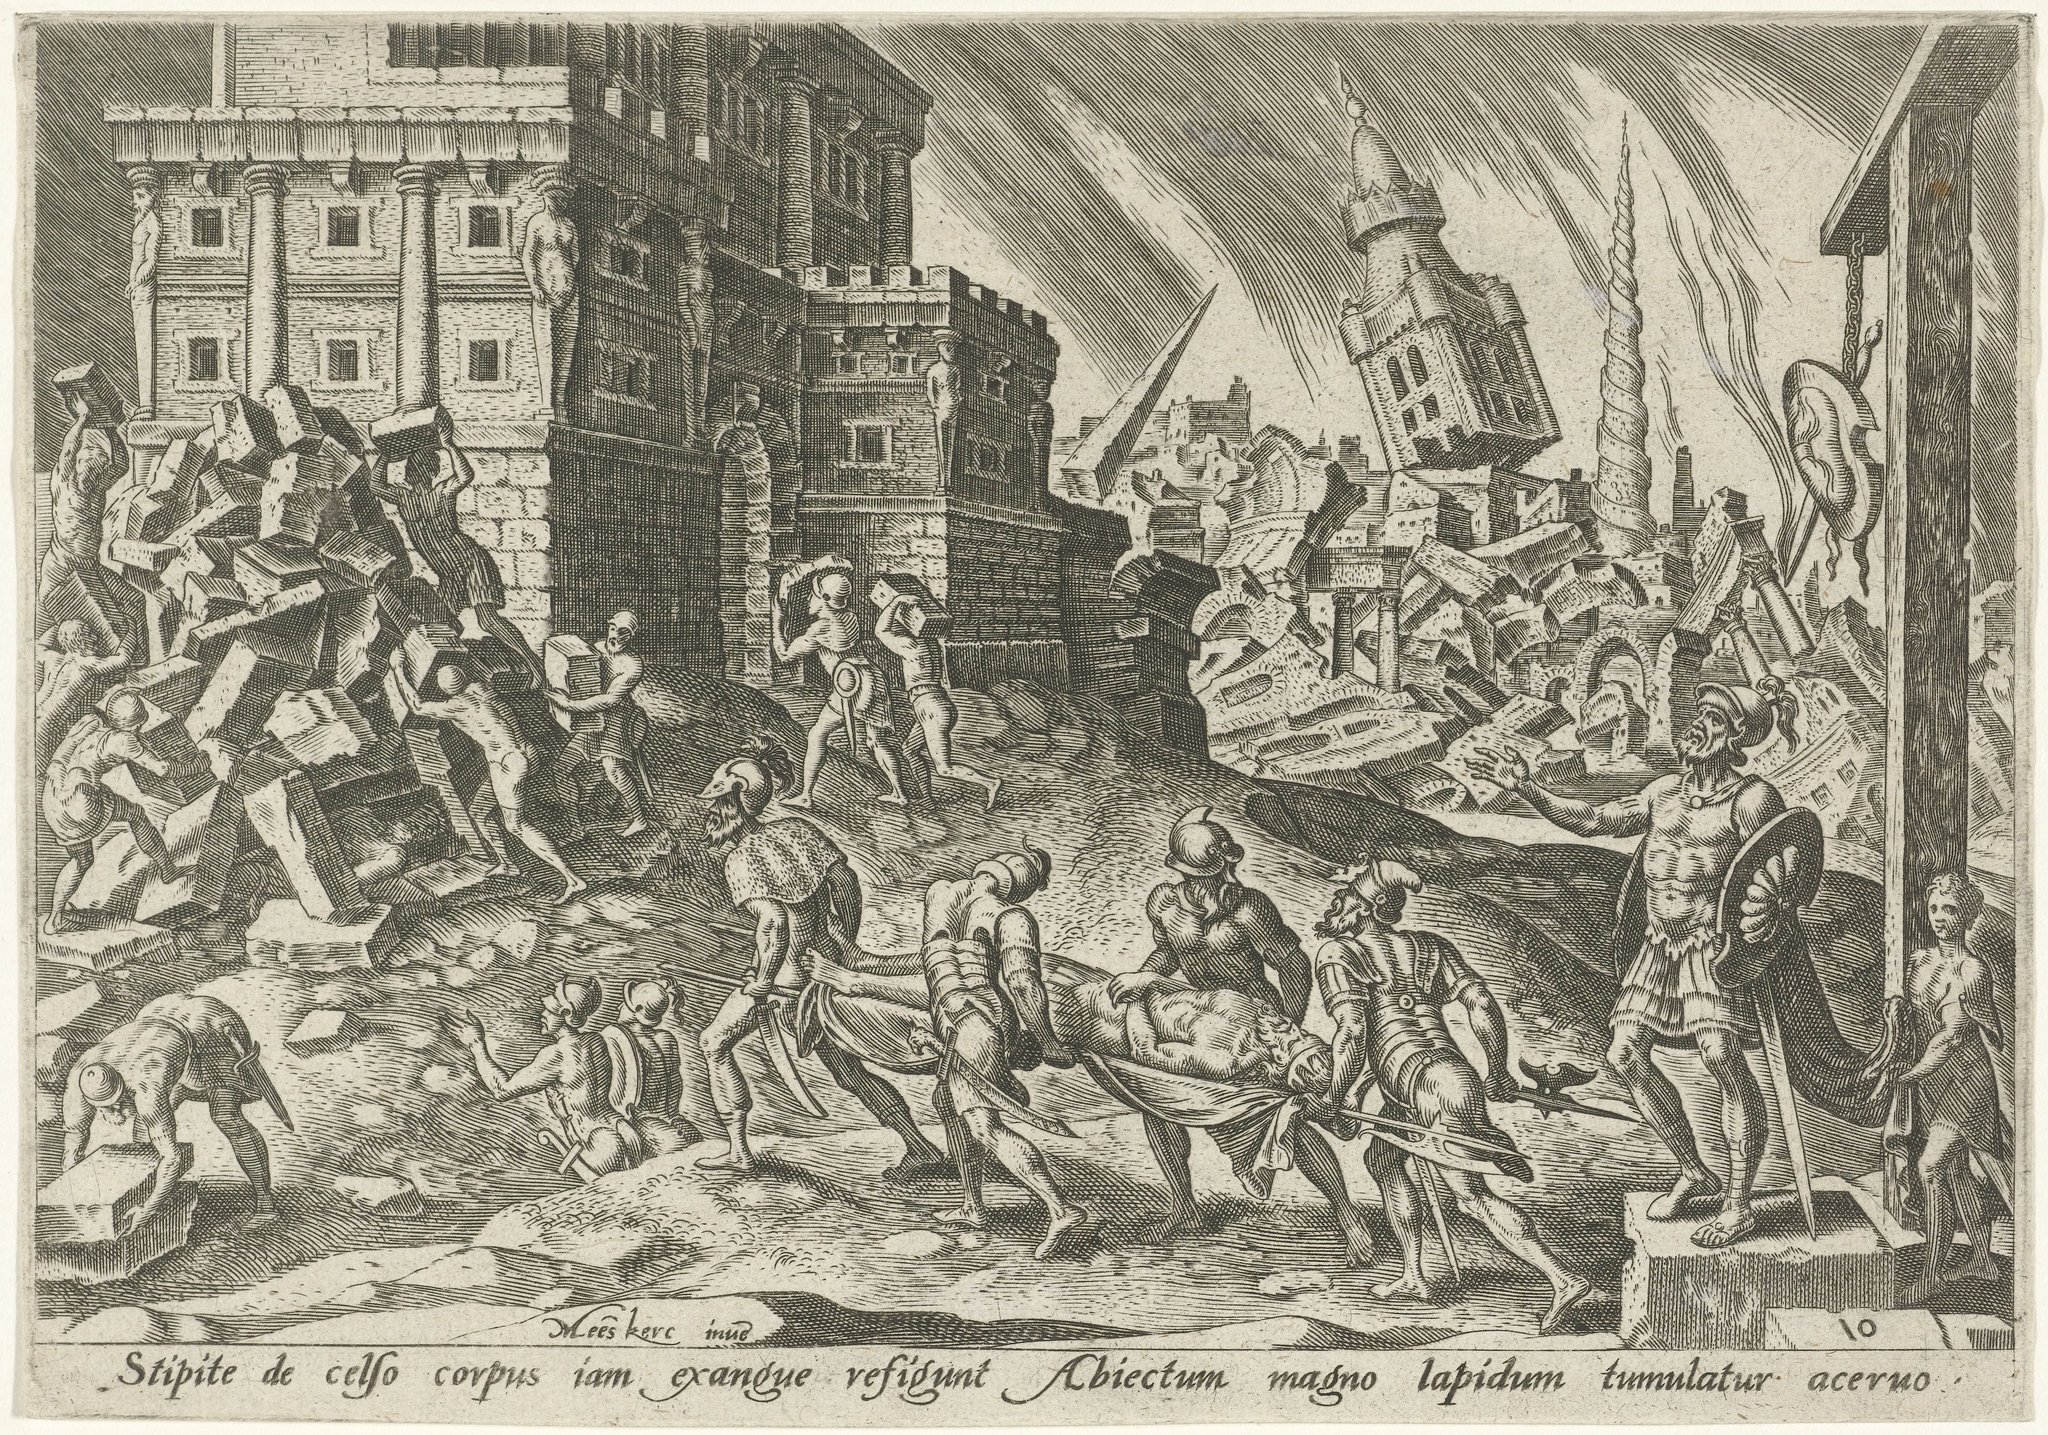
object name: print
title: Het lichaam van de koning van Ai wordt naar de stadspoort gebracht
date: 1569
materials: paper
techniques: engraving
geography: haarlem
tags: the body of the king of ai is removed from the tree on which he had been hanged, thrown down before the city-gate and covered with a huge pile of stones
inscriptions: caption: ‘Stipite de celso corpus exangue refigunt...tumulator acero.’, number: ‘10’, signature: ‘MHee[m]s kerc inve.’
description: Het dode lichaam van de koning van Ai wordt op een baar door soldaten naar de stadspoort gedragen. Op de achtergrond de verwoeste stad.